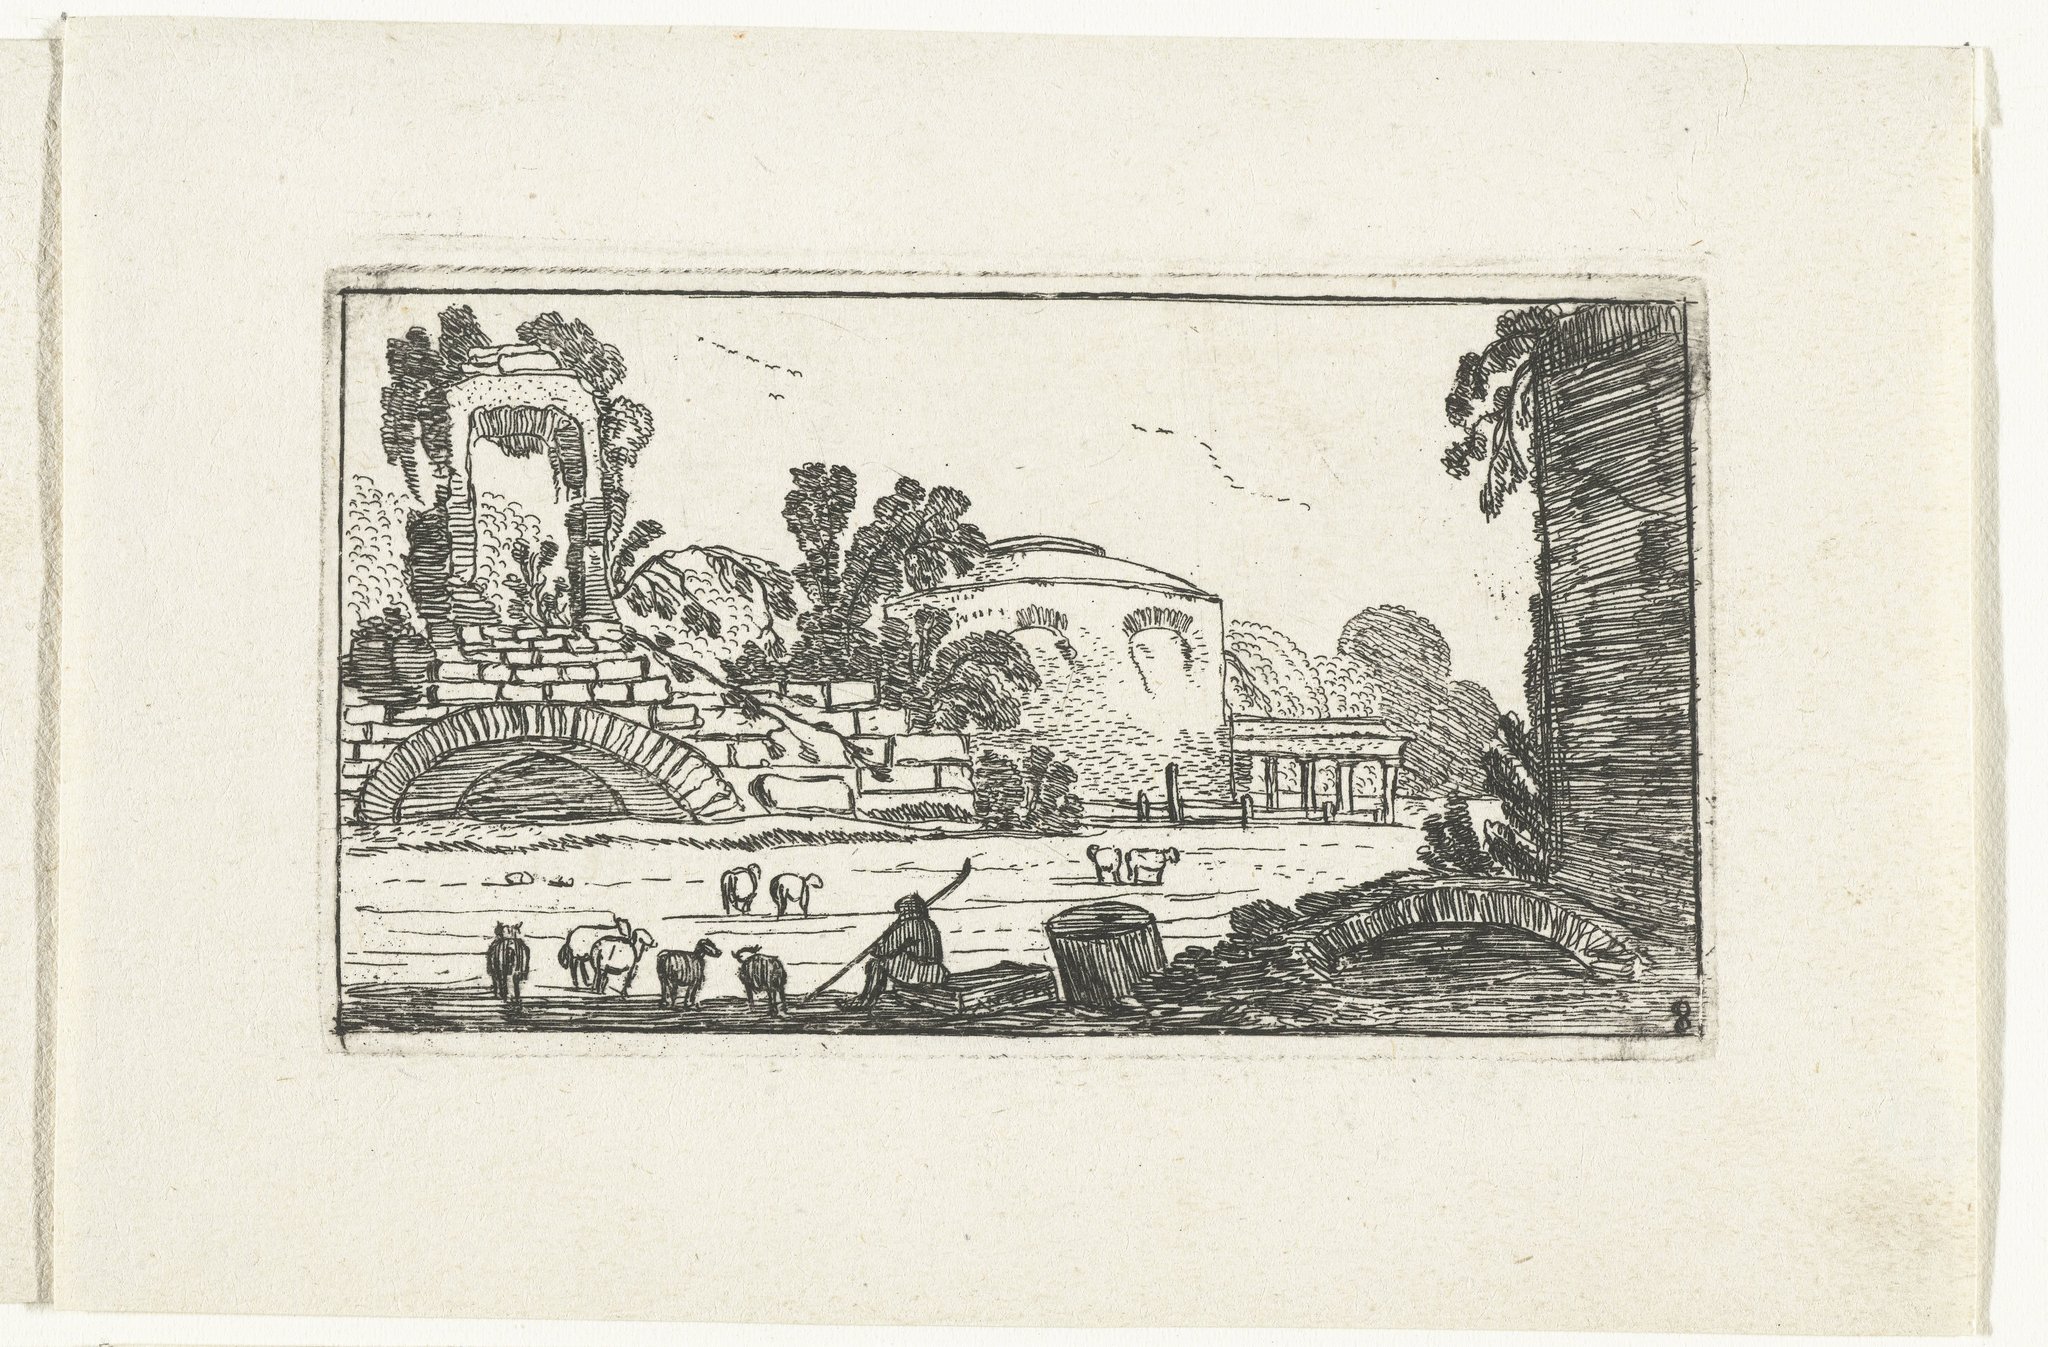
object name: print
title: Landschap met ruïnes en herder met schapen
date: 1610-1617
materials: paper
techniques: etching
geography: haarlem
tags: landscape with ruins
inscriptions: collector's mark: Lugt 2228a